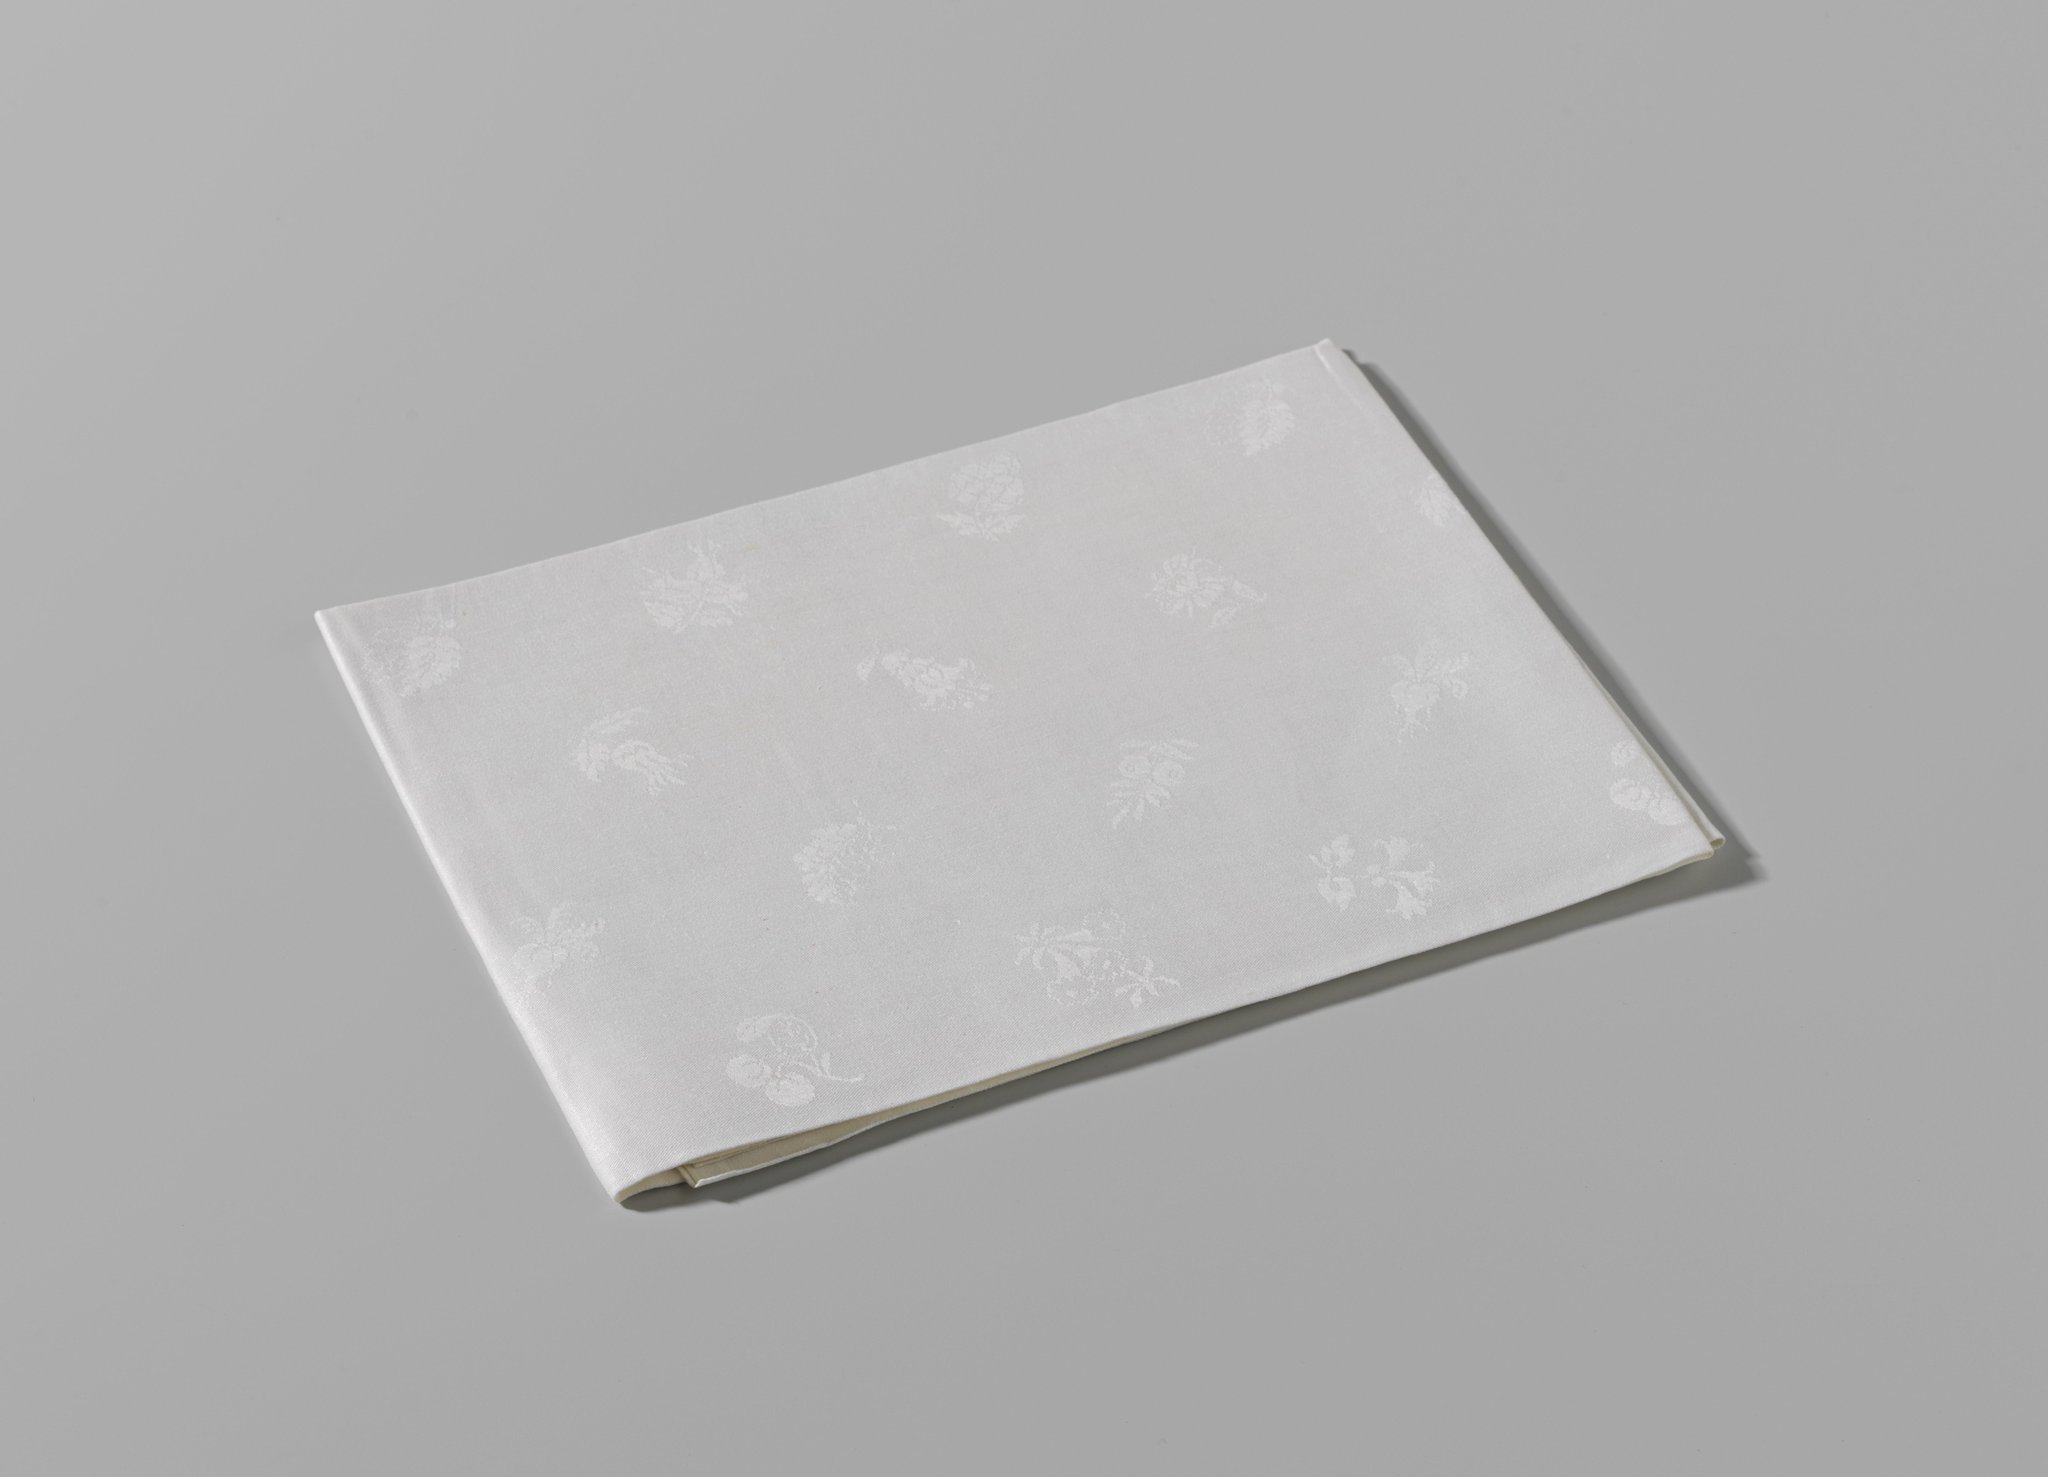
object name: napkin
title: Servet met patroon van diverse vruchten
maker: Anonymous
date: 1800-1900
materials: linen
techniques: damask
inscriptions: label: ‘R.M. A'dam’, number: ‘36’, monogram: ‘TvBF’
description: Servet van linnendamast met patroon van diverse vruchten en bloemen op het middenveld.